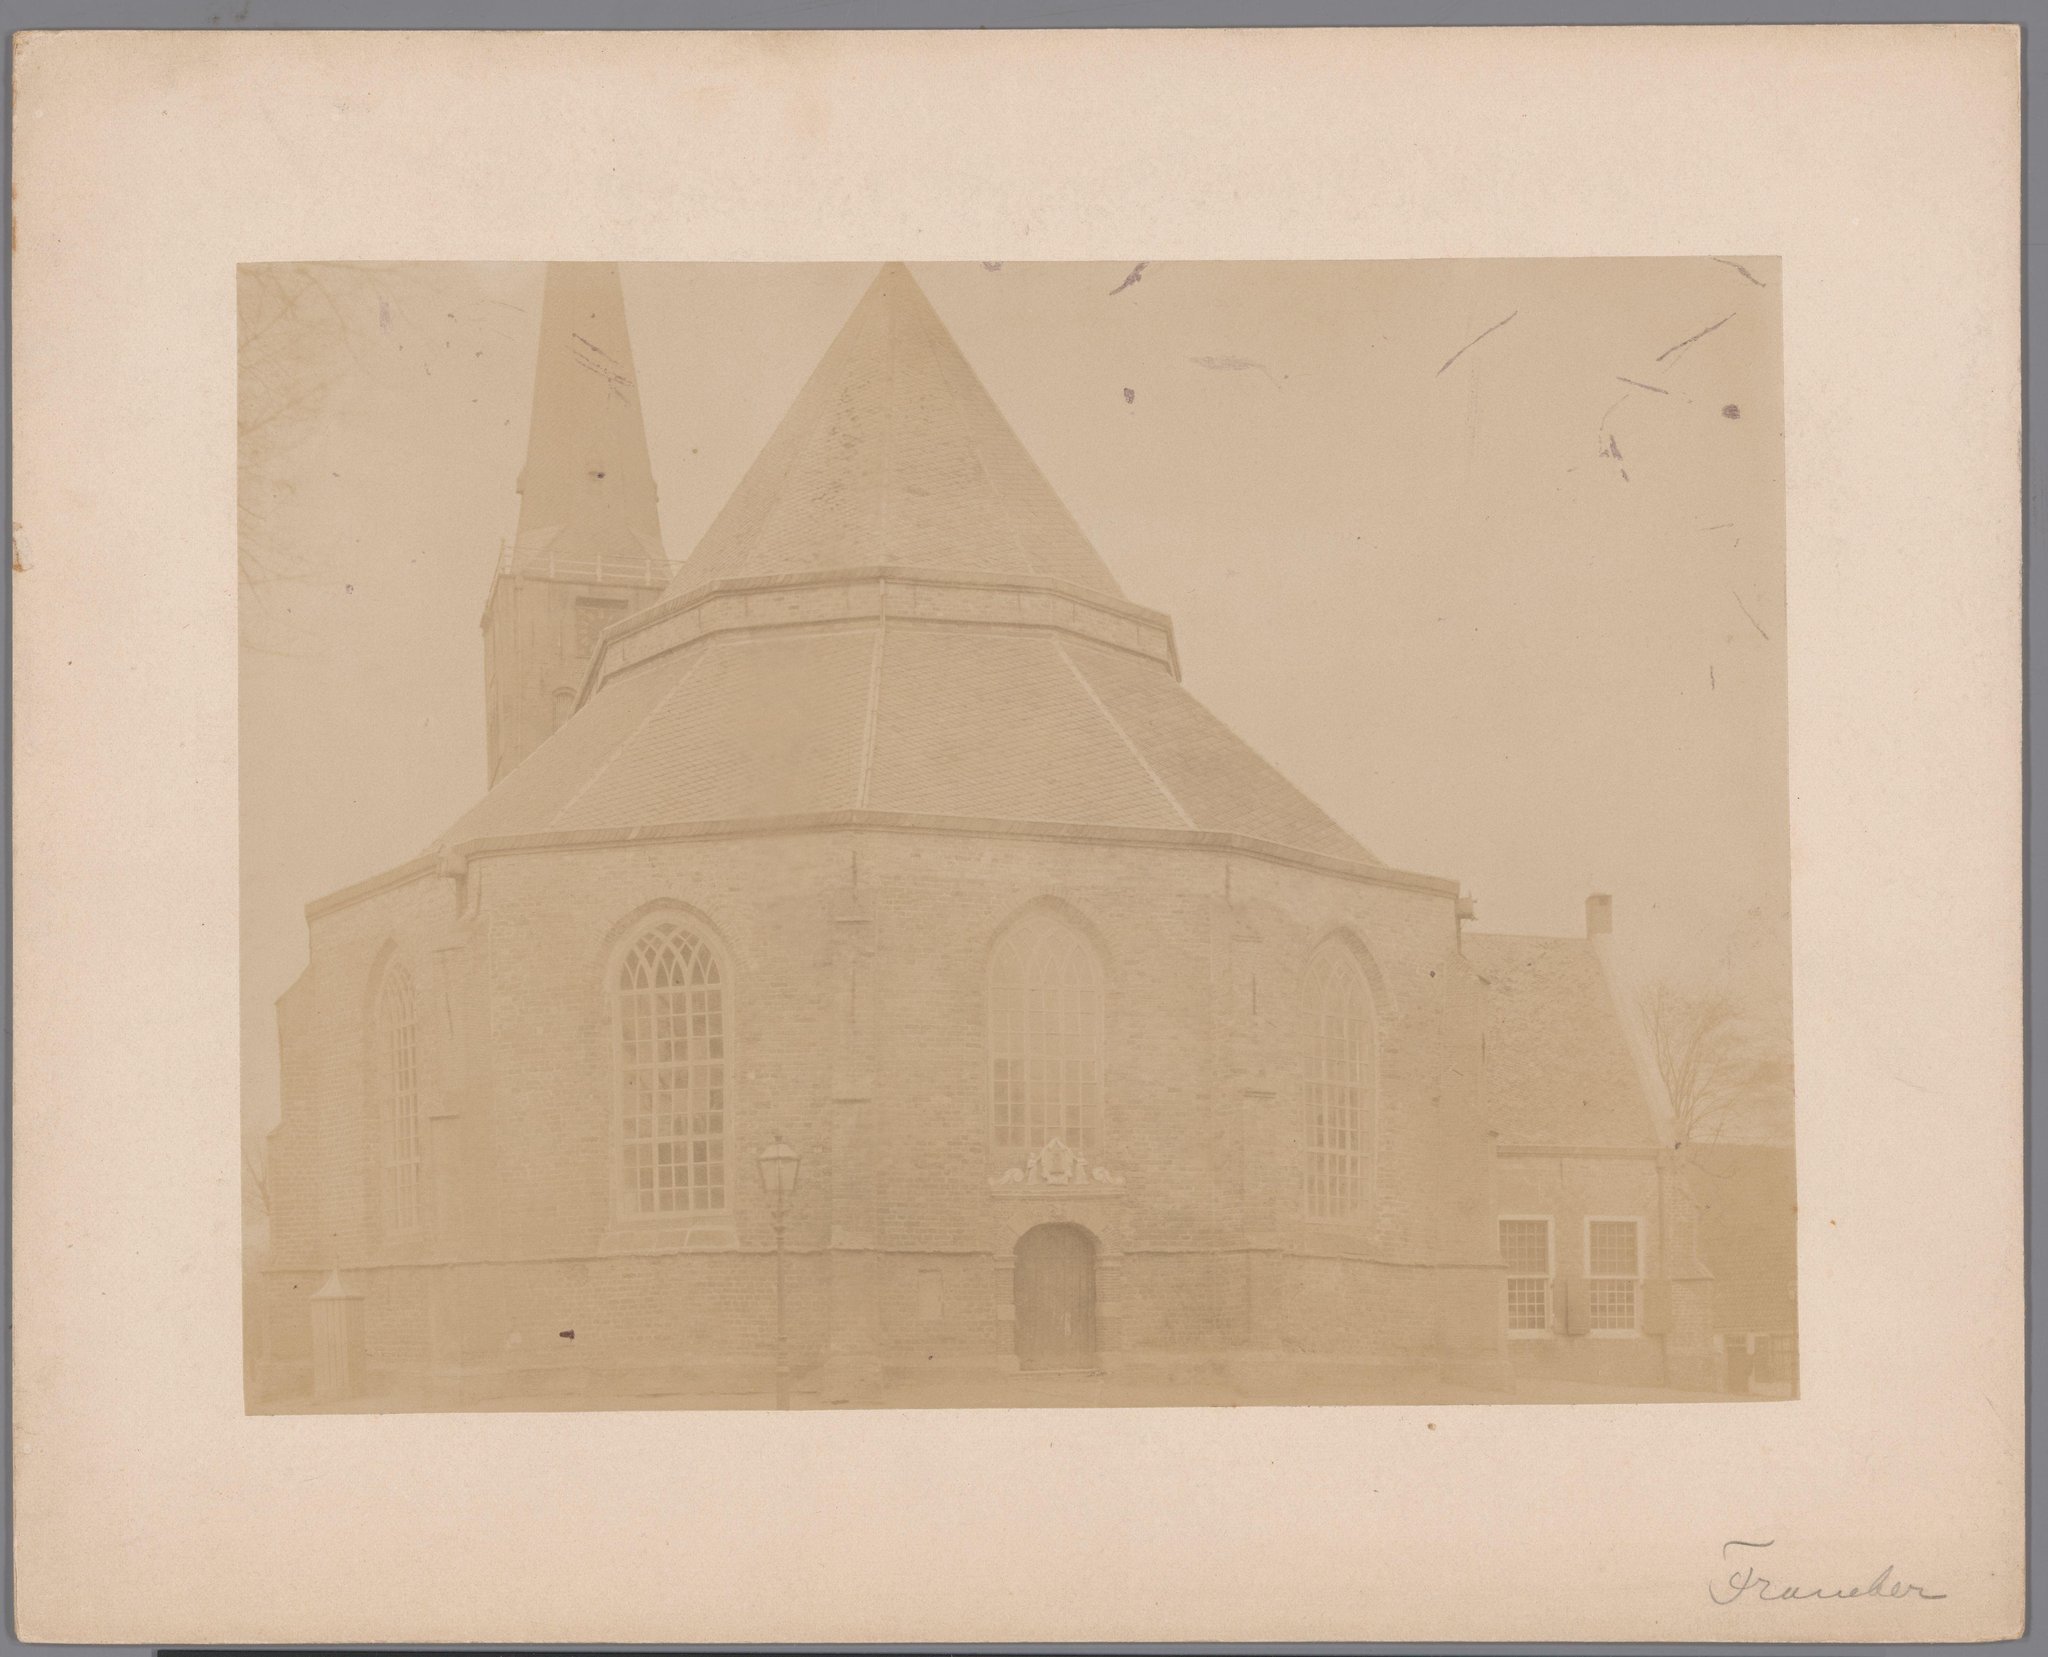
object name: photograph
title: Martinikerk te Franeker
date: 1890-1915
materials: cardboard, photographic support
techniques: albumen print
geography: franeker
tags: church (exterior)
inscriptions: annotation: ‘Kerk der N.H. gemeente / te / Franeker (Fr.)’, annotation: ‘Franeker’